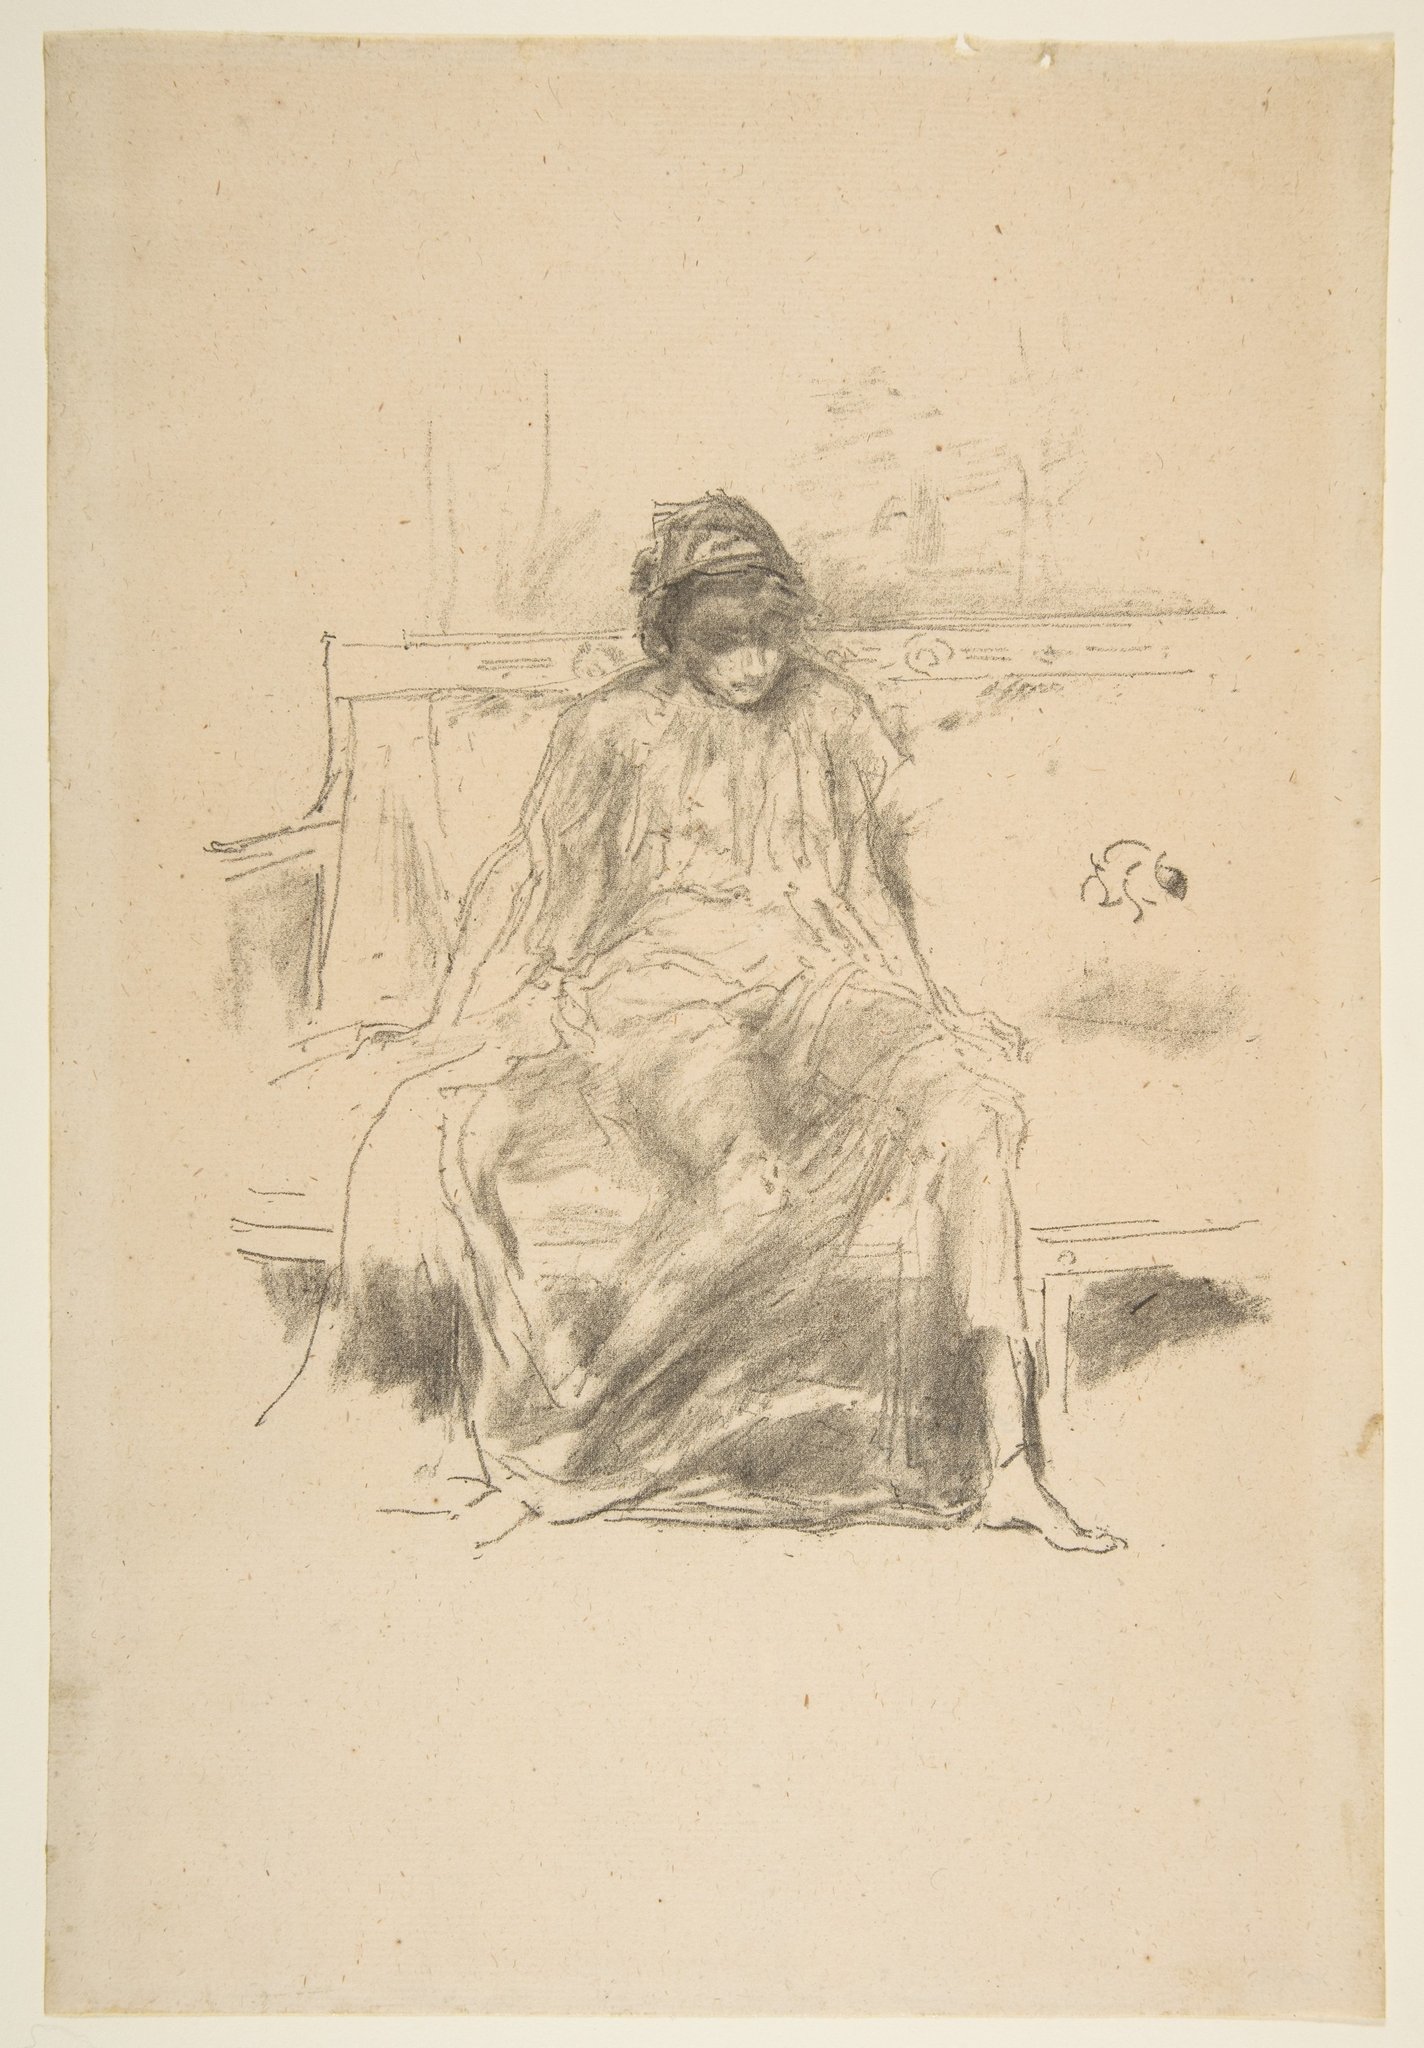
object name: print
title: The Draped Figure, Seated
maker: james mcneill whistler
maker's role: artist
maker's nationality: american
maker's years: 1834-1903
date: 1893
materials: paper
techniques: printing, stumping, lithography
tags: women